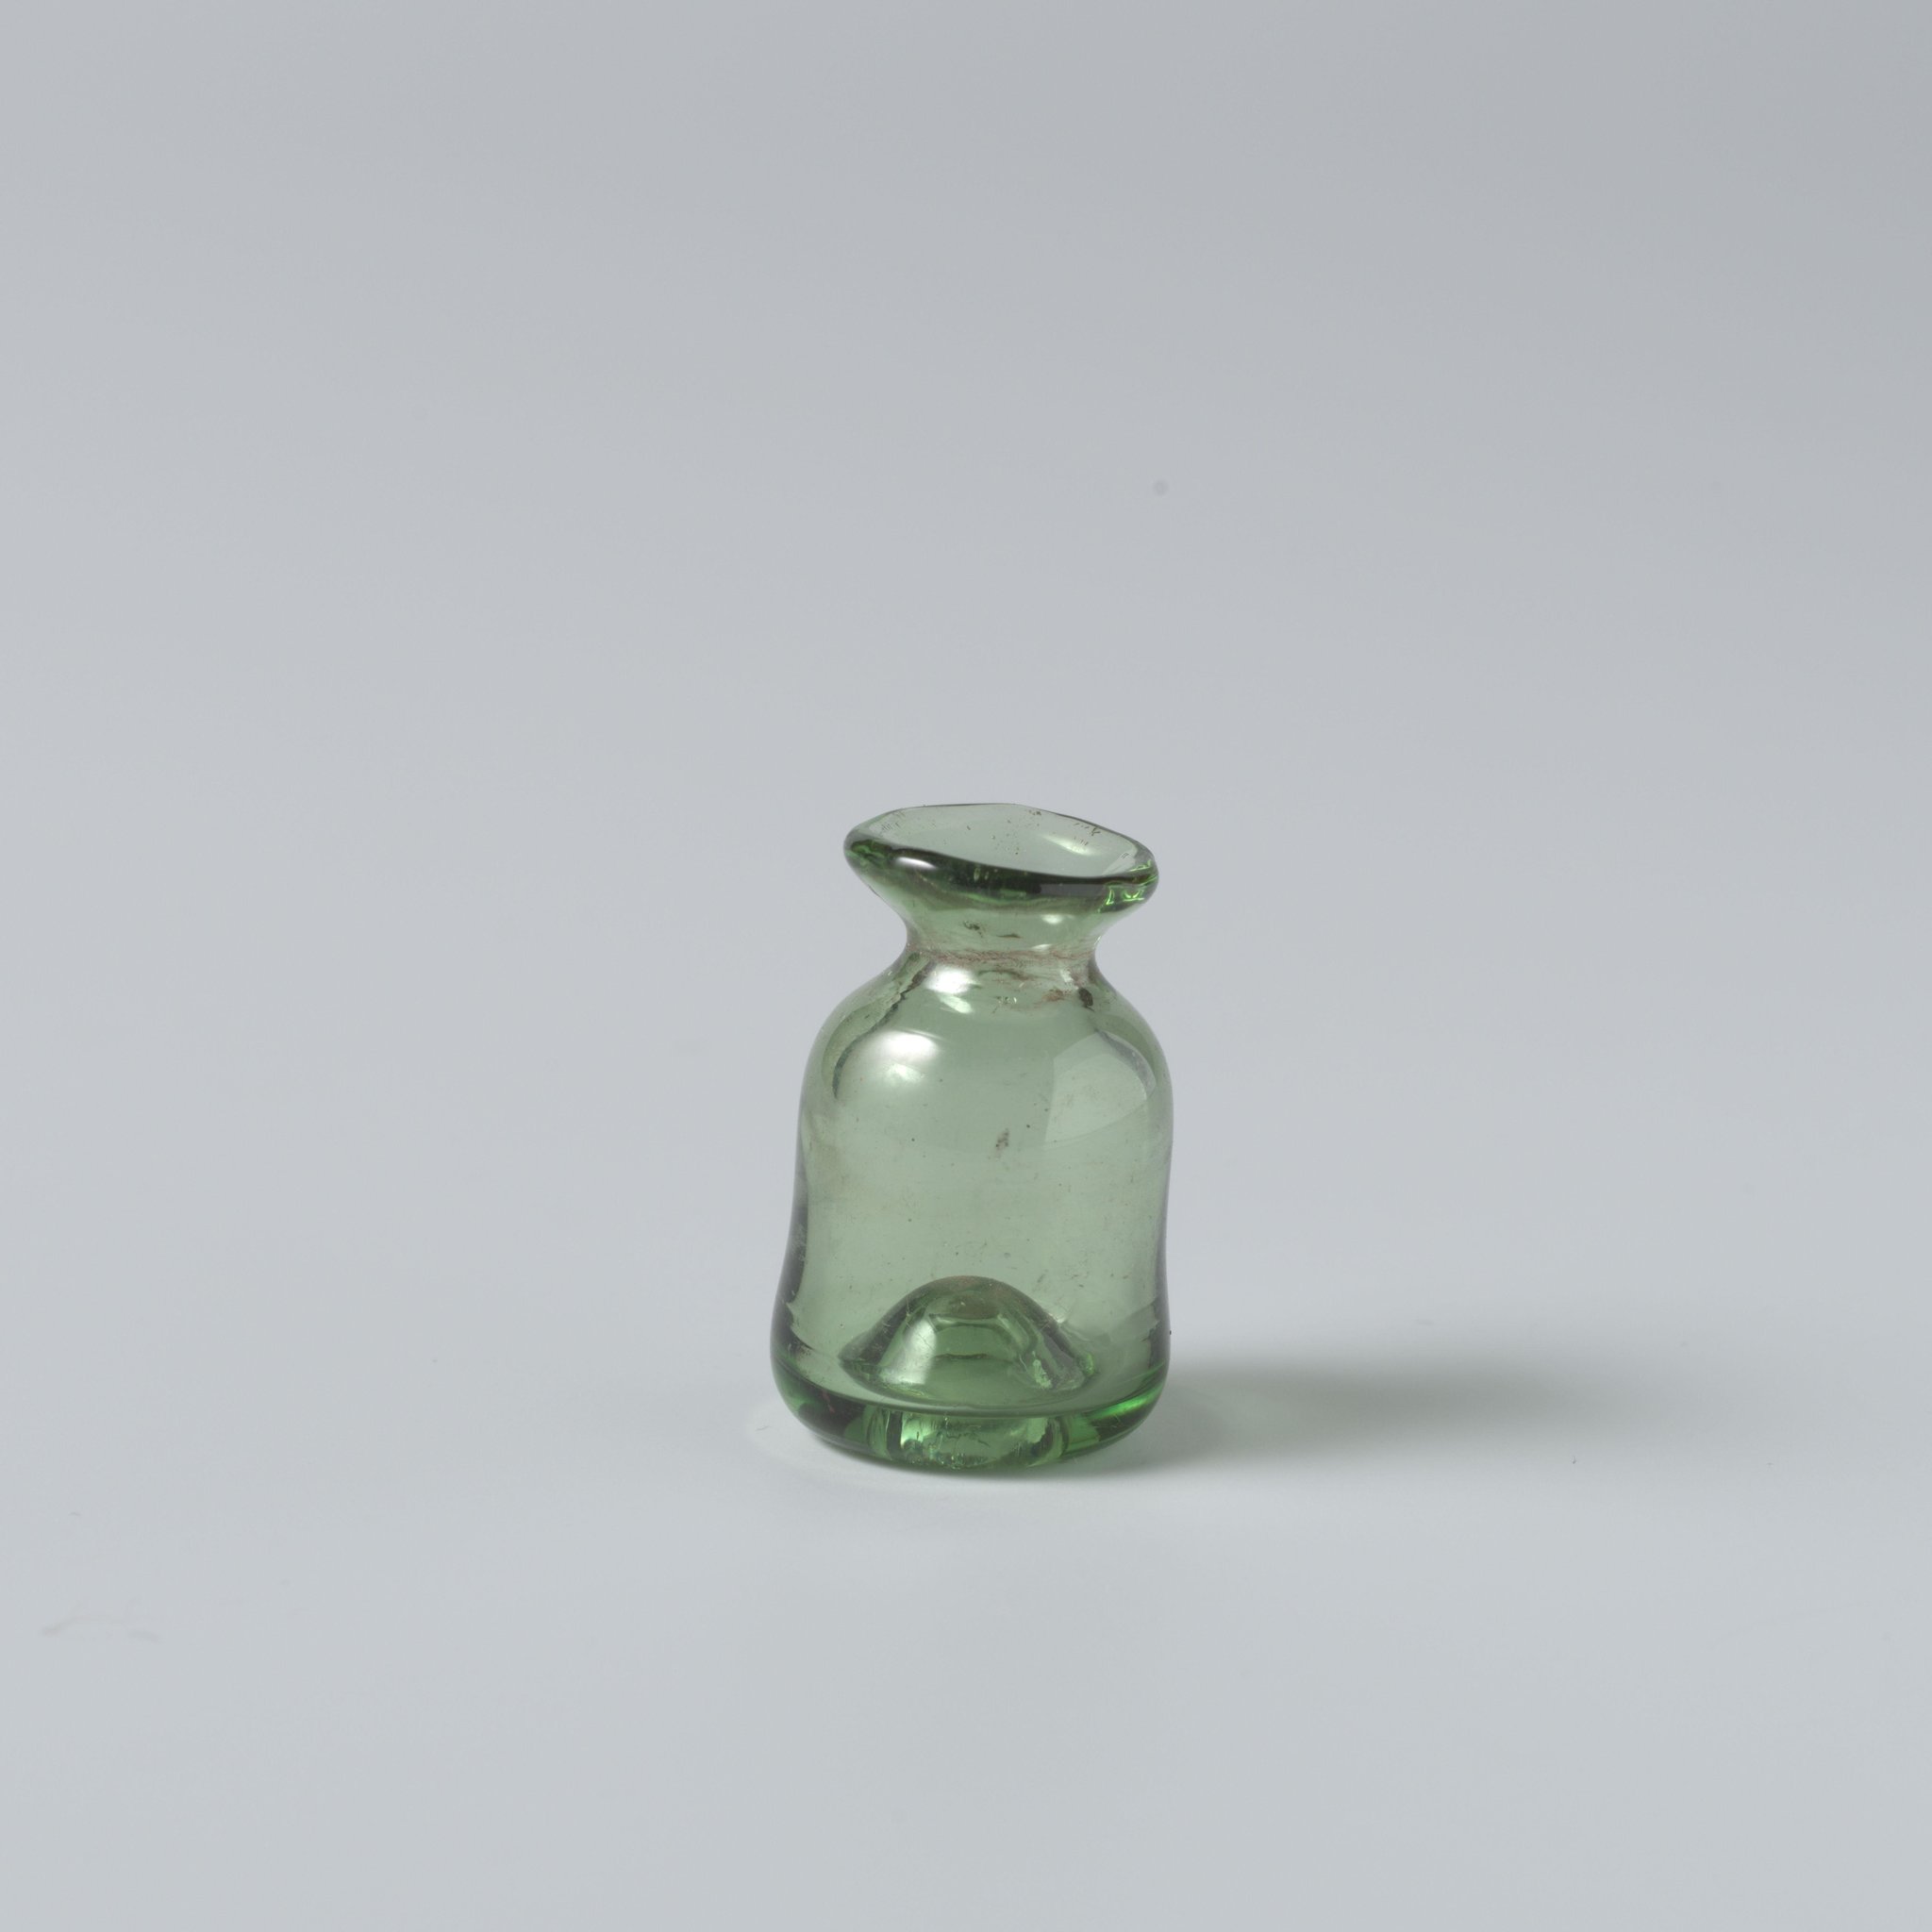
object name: voorraadfles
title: Voorraadfles, cilindervormig, met ingestoken ziel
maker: Anonymous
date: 1700-1799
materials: glass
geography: netherlands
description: Voorraadfles van helder groen glas, cilindervormig, met ingestoken ziel en hals met wijduitstaande rand.